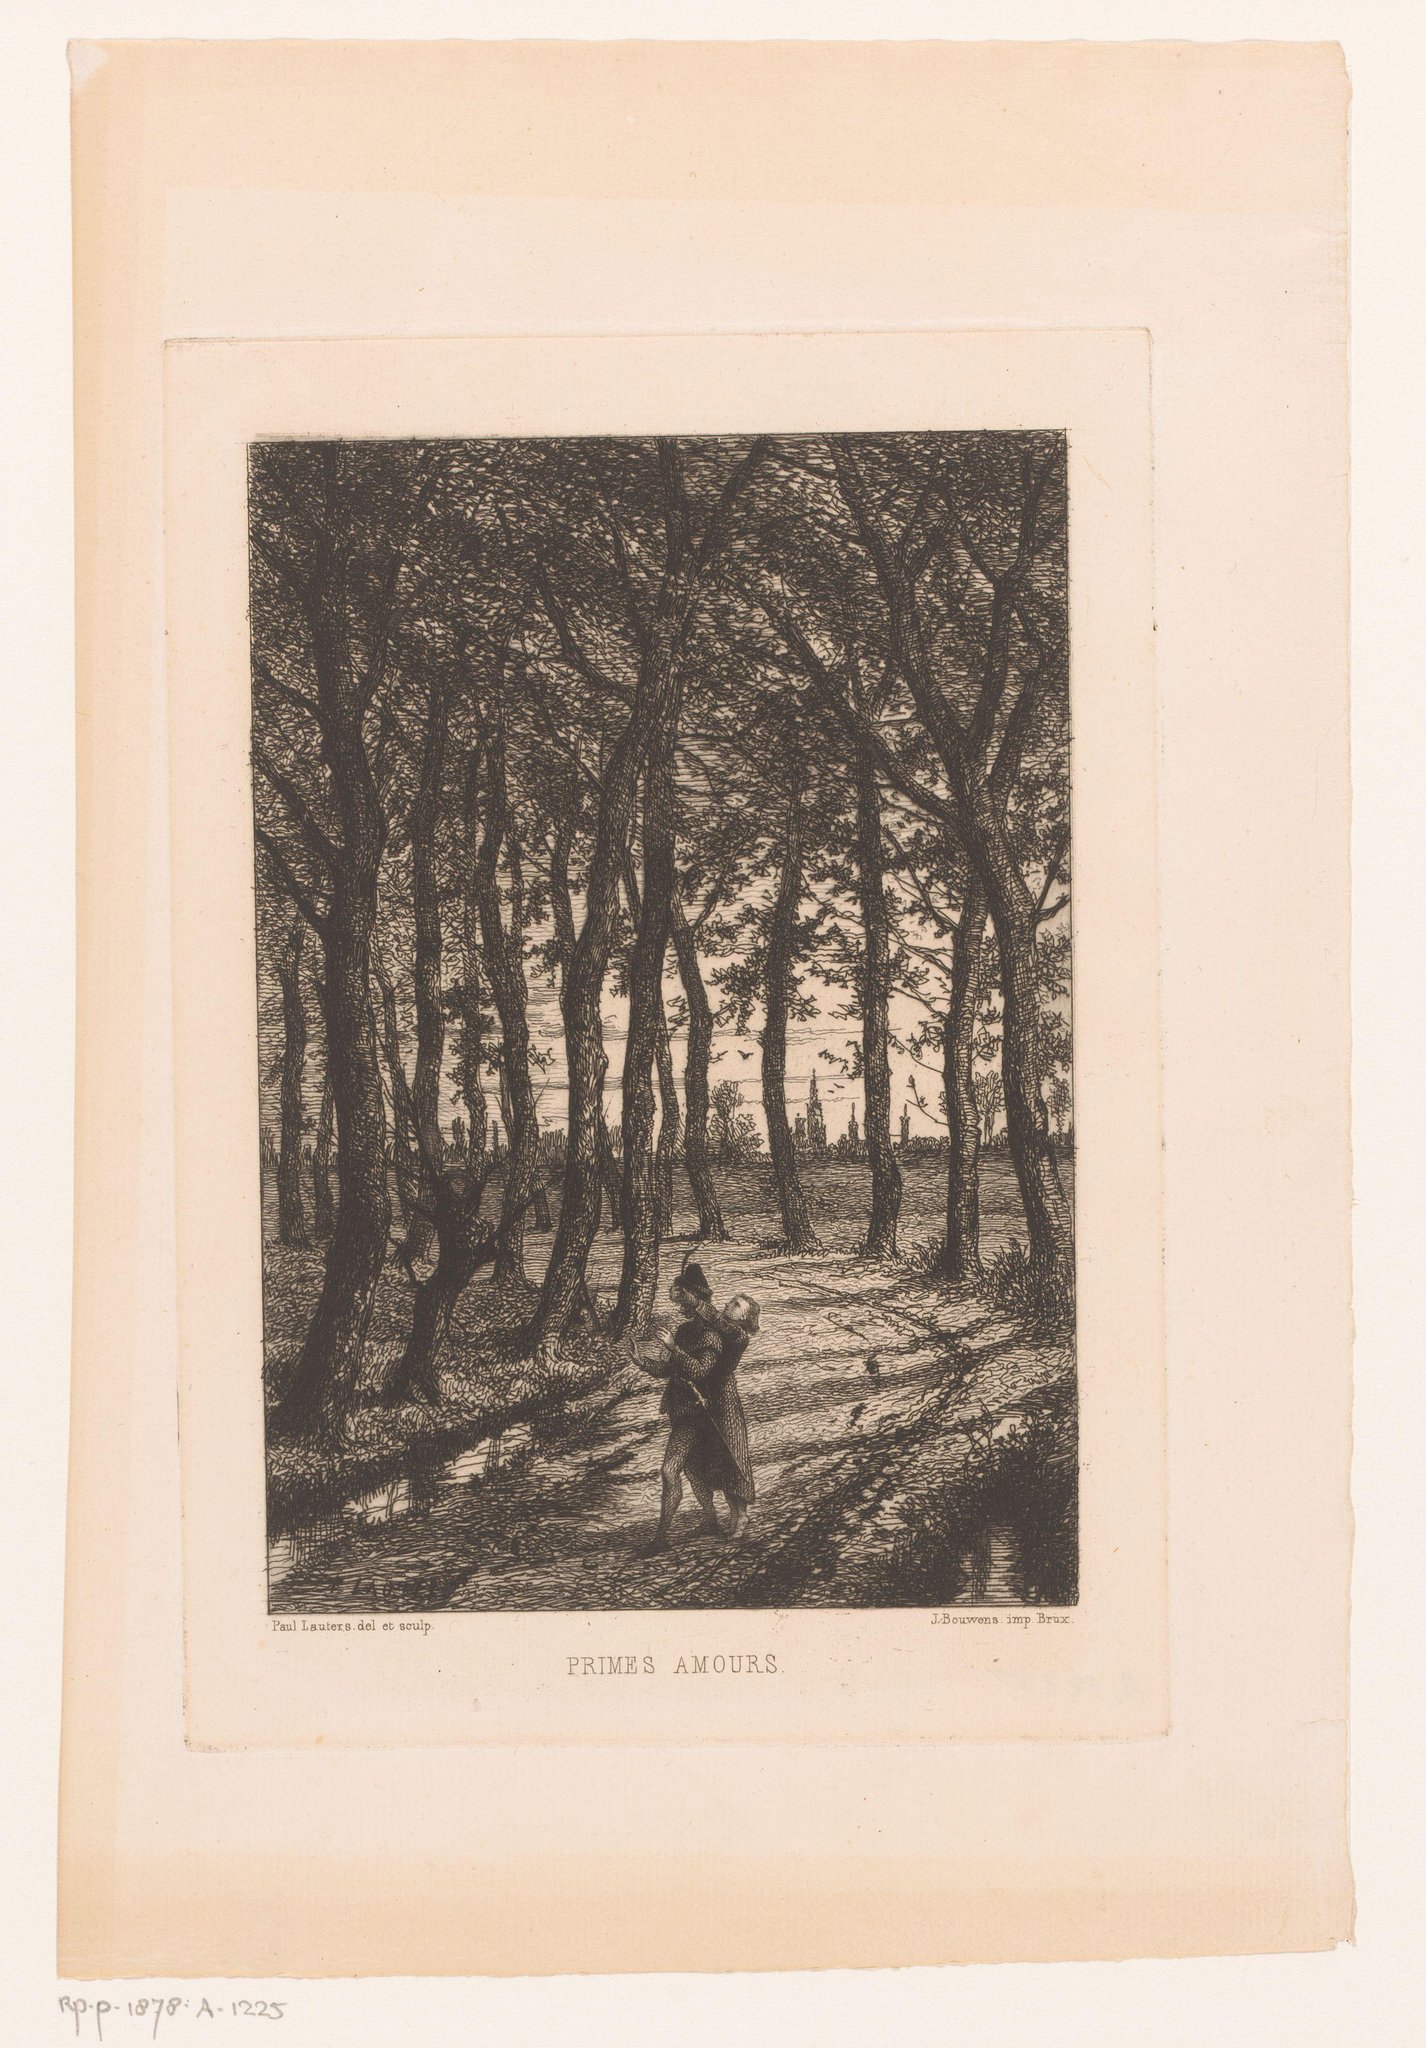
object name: print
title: Primes amours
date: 1869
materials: paper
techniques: drypoint, etching, intaglio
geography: brussels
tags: forest path or lane, lovers' meeting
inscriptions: collector's mark: Lugt 2228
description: Prent uit: Coster, Charles de. La légende et les aventures héroiques, joyeuses et glorieuses d'Ulenspiegel et de Lamme Goedzak au pays de Flandres et ailleurs. 2de druk. Parijs: Librairie Internationale, 1869, p. 58.